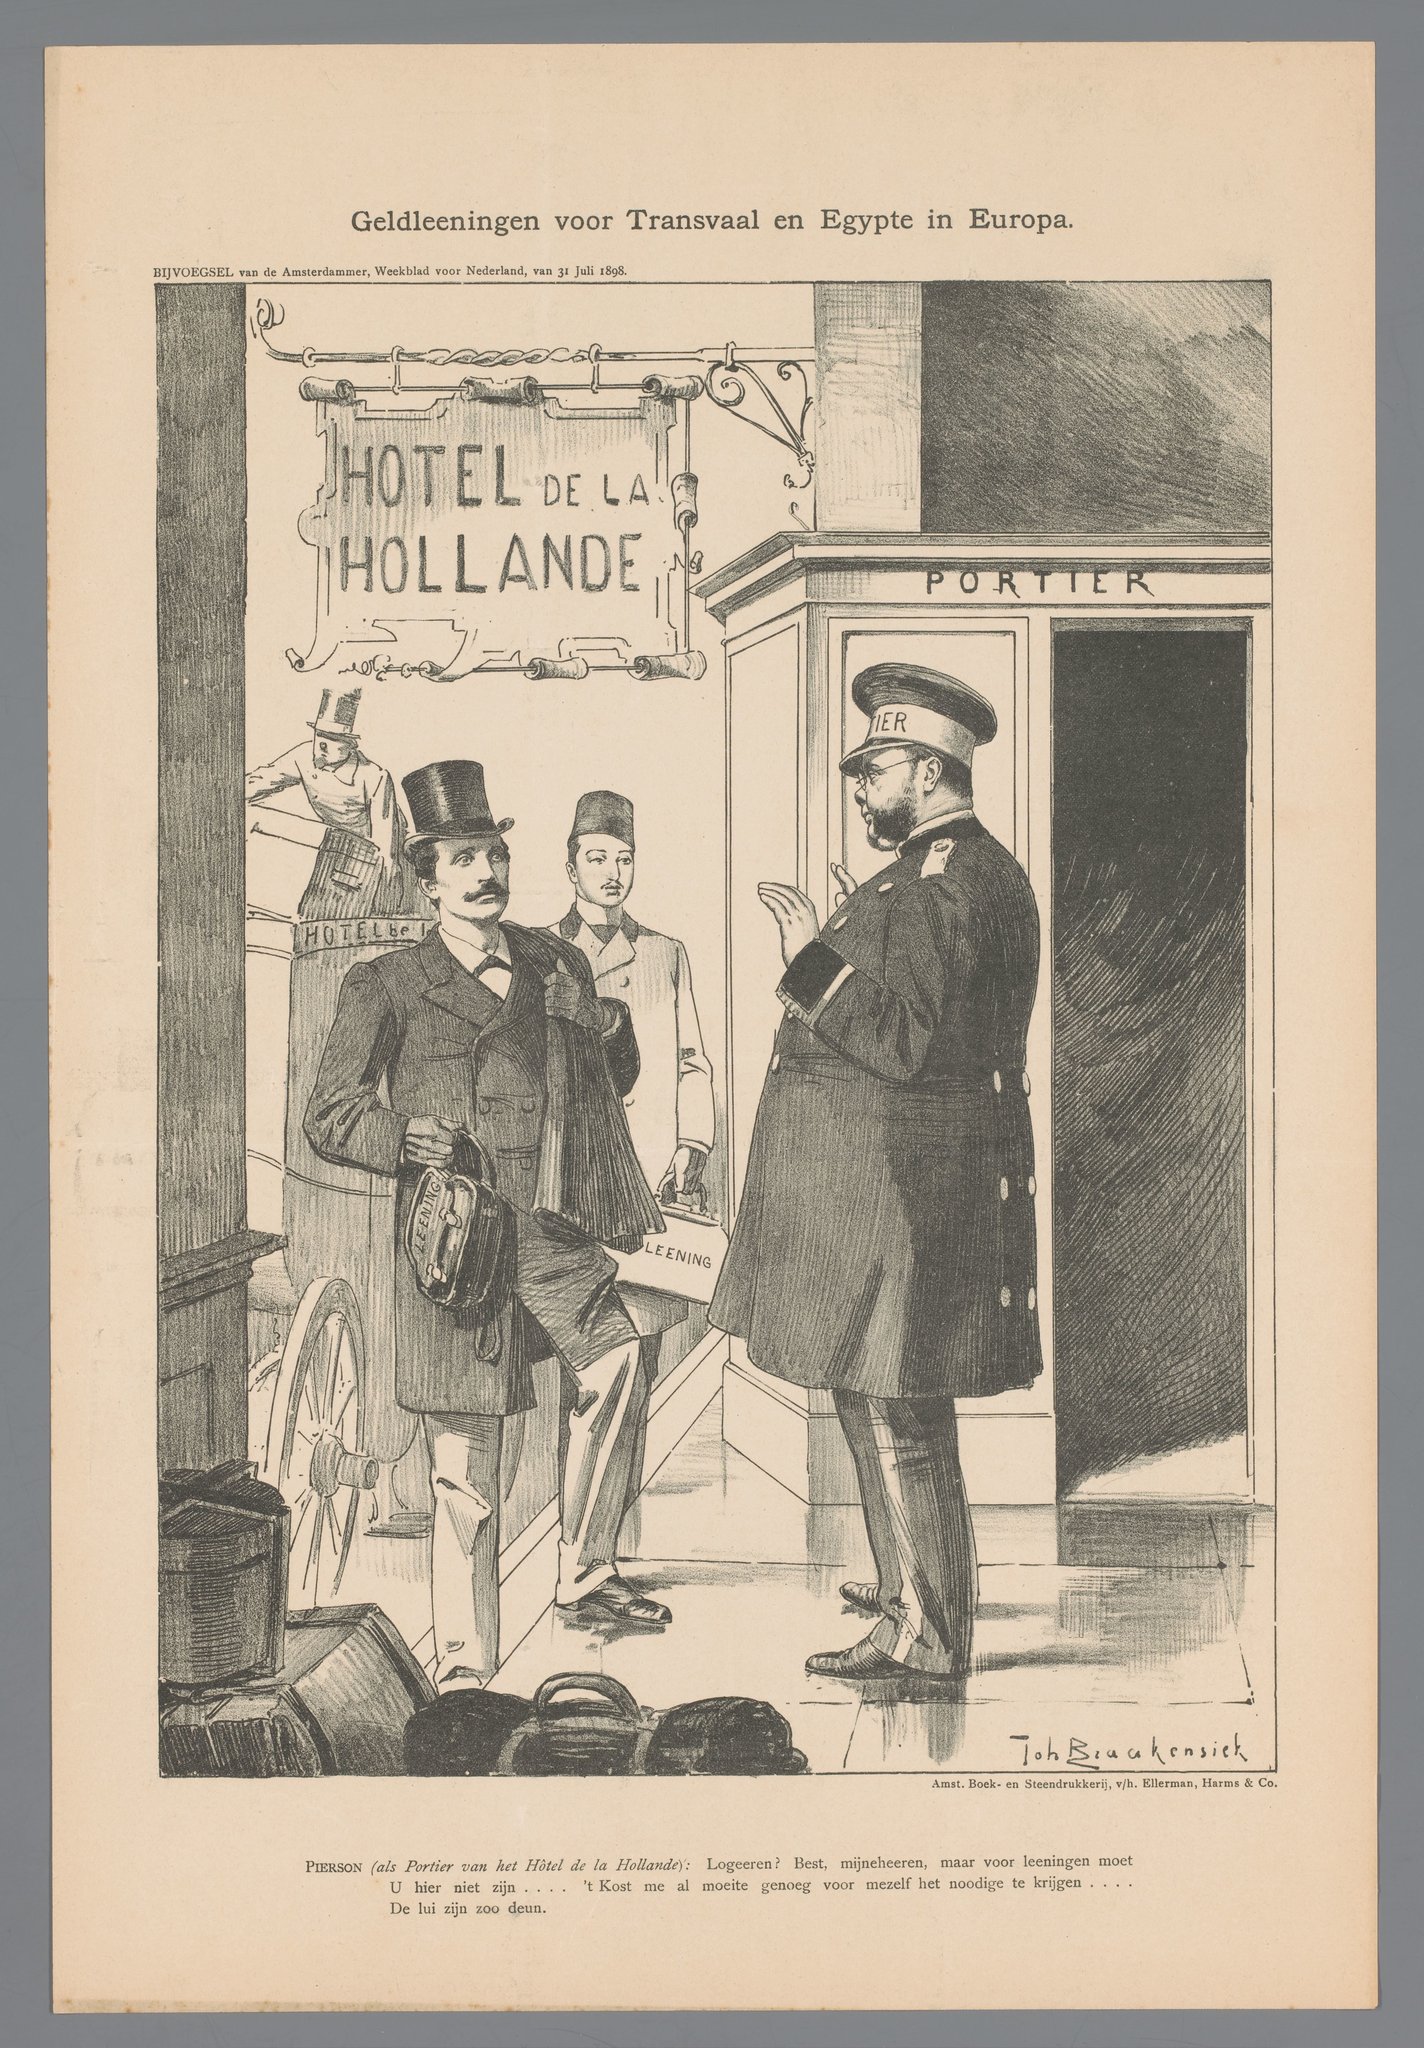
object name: cartoon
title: Geldleeningen voor Transvaal en Egypte in Europa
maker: johan braakensiek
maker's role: draughtsman, print maker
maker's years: 1858-1940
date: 1898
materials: paper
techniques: lithograph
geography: amsterdam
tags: amsterdam, politician, nicolaas gerard pierson, historical persons, hotel, hostelry, inn, political caricatures and satires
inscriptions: date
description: Prent uit het bijvoegsel van: De Amsterdammer. Weekblad voor Nederland, 31 juli 1898.